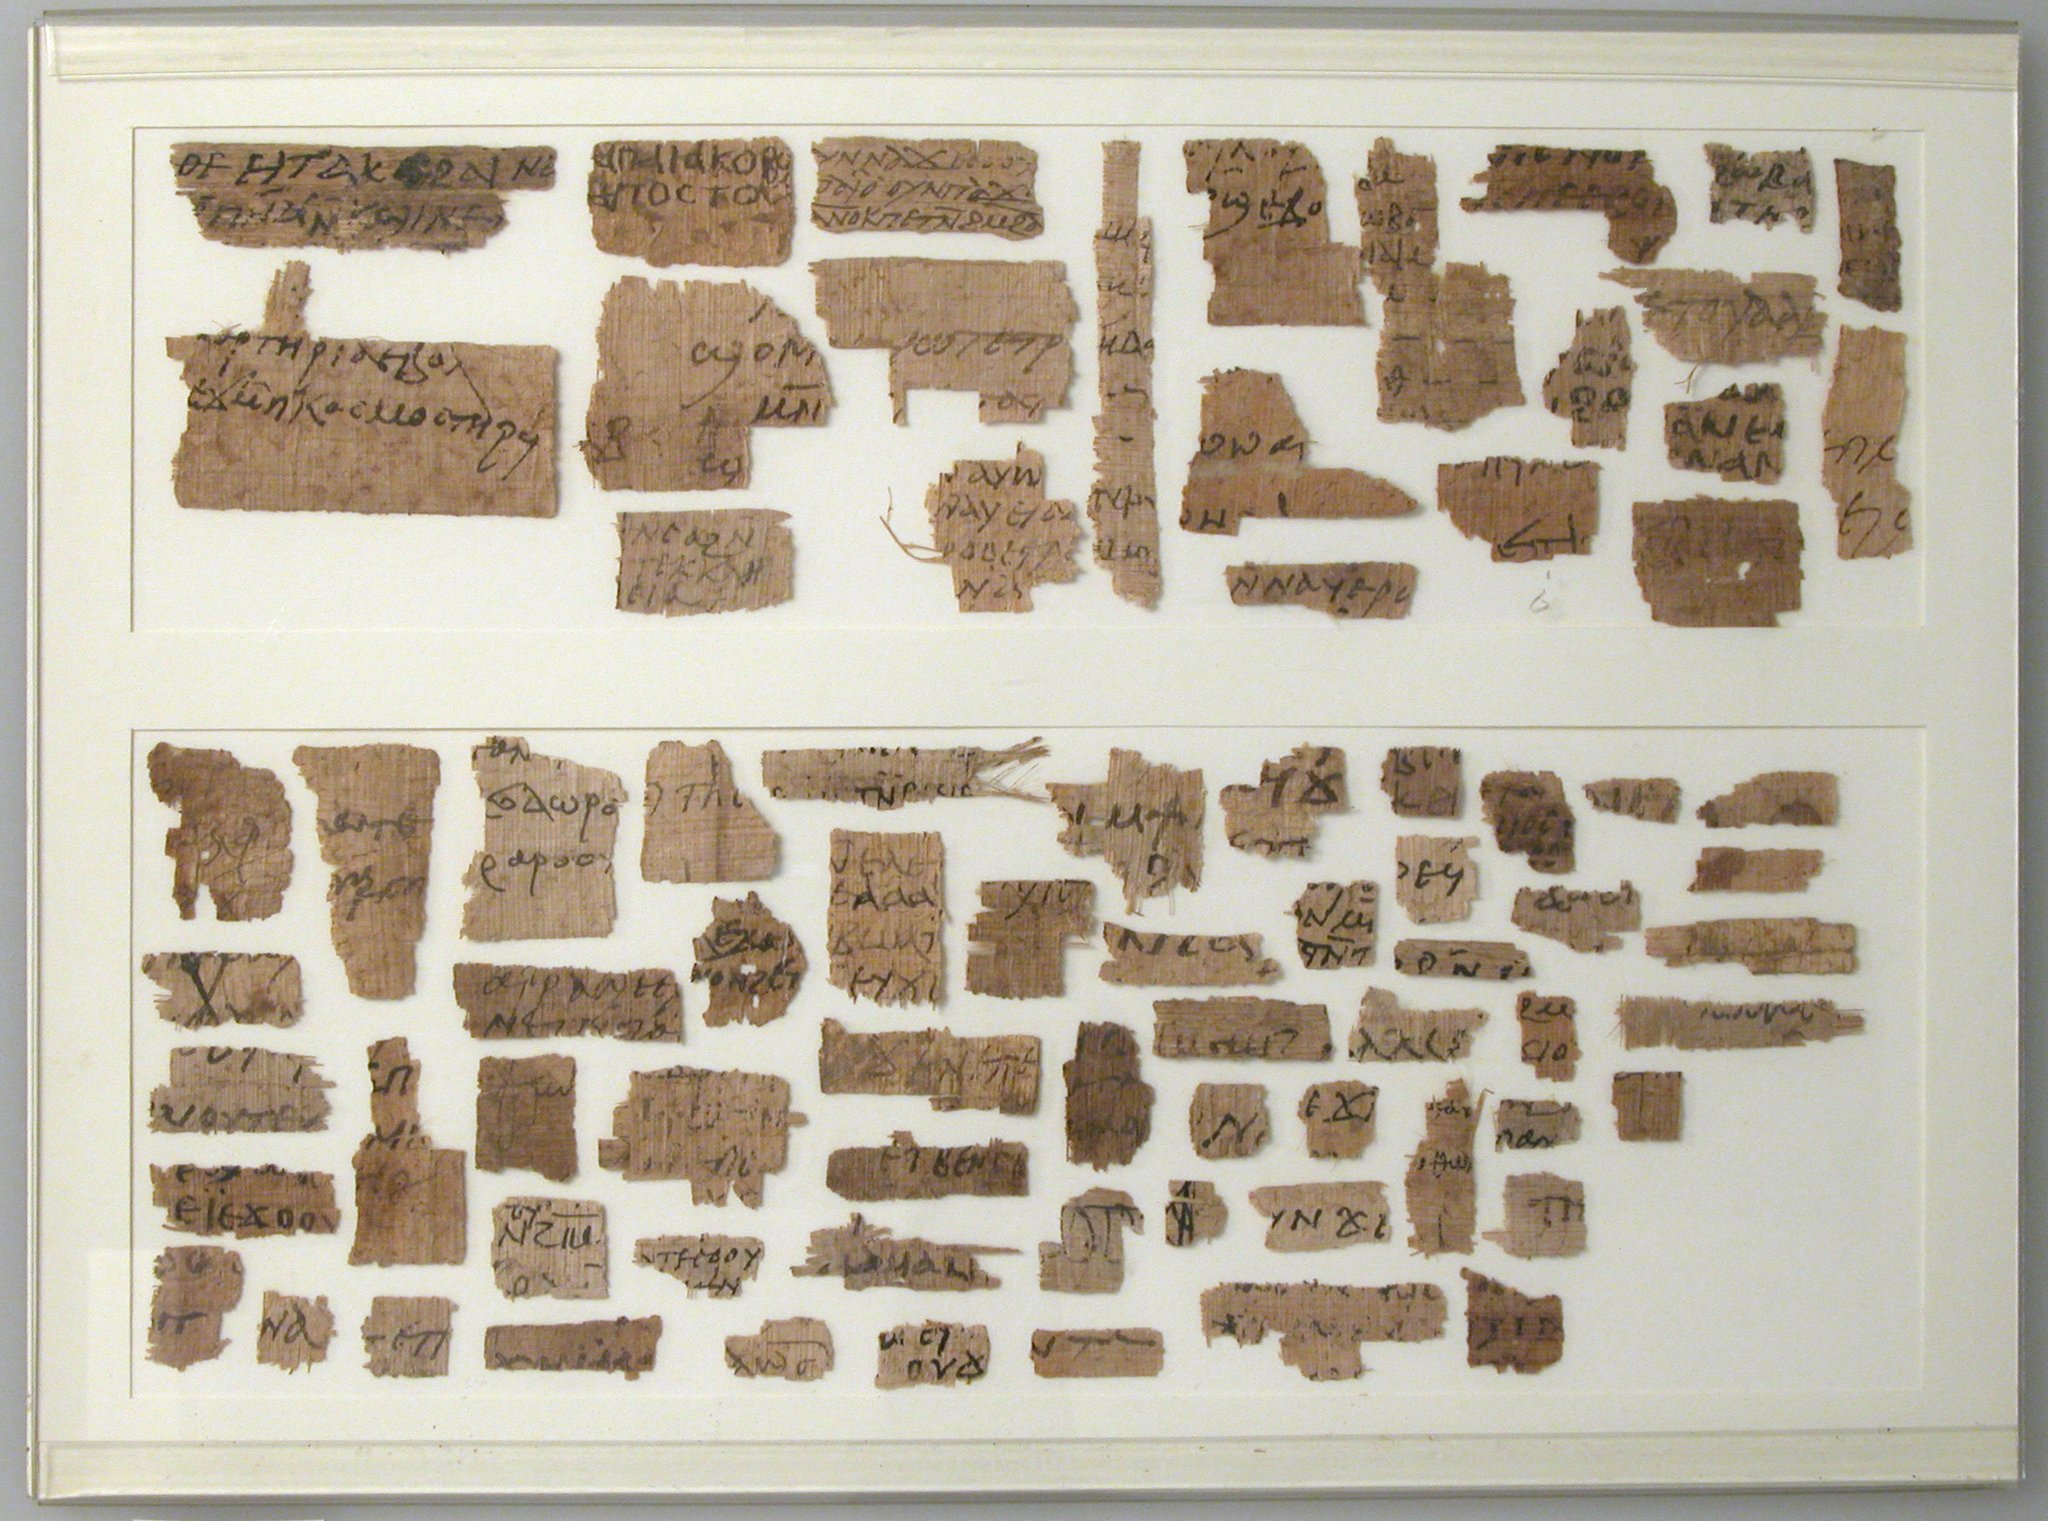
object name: fragment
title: Papyri Fragments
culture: coptic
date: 601-700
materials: ink, papyrus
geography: egypt